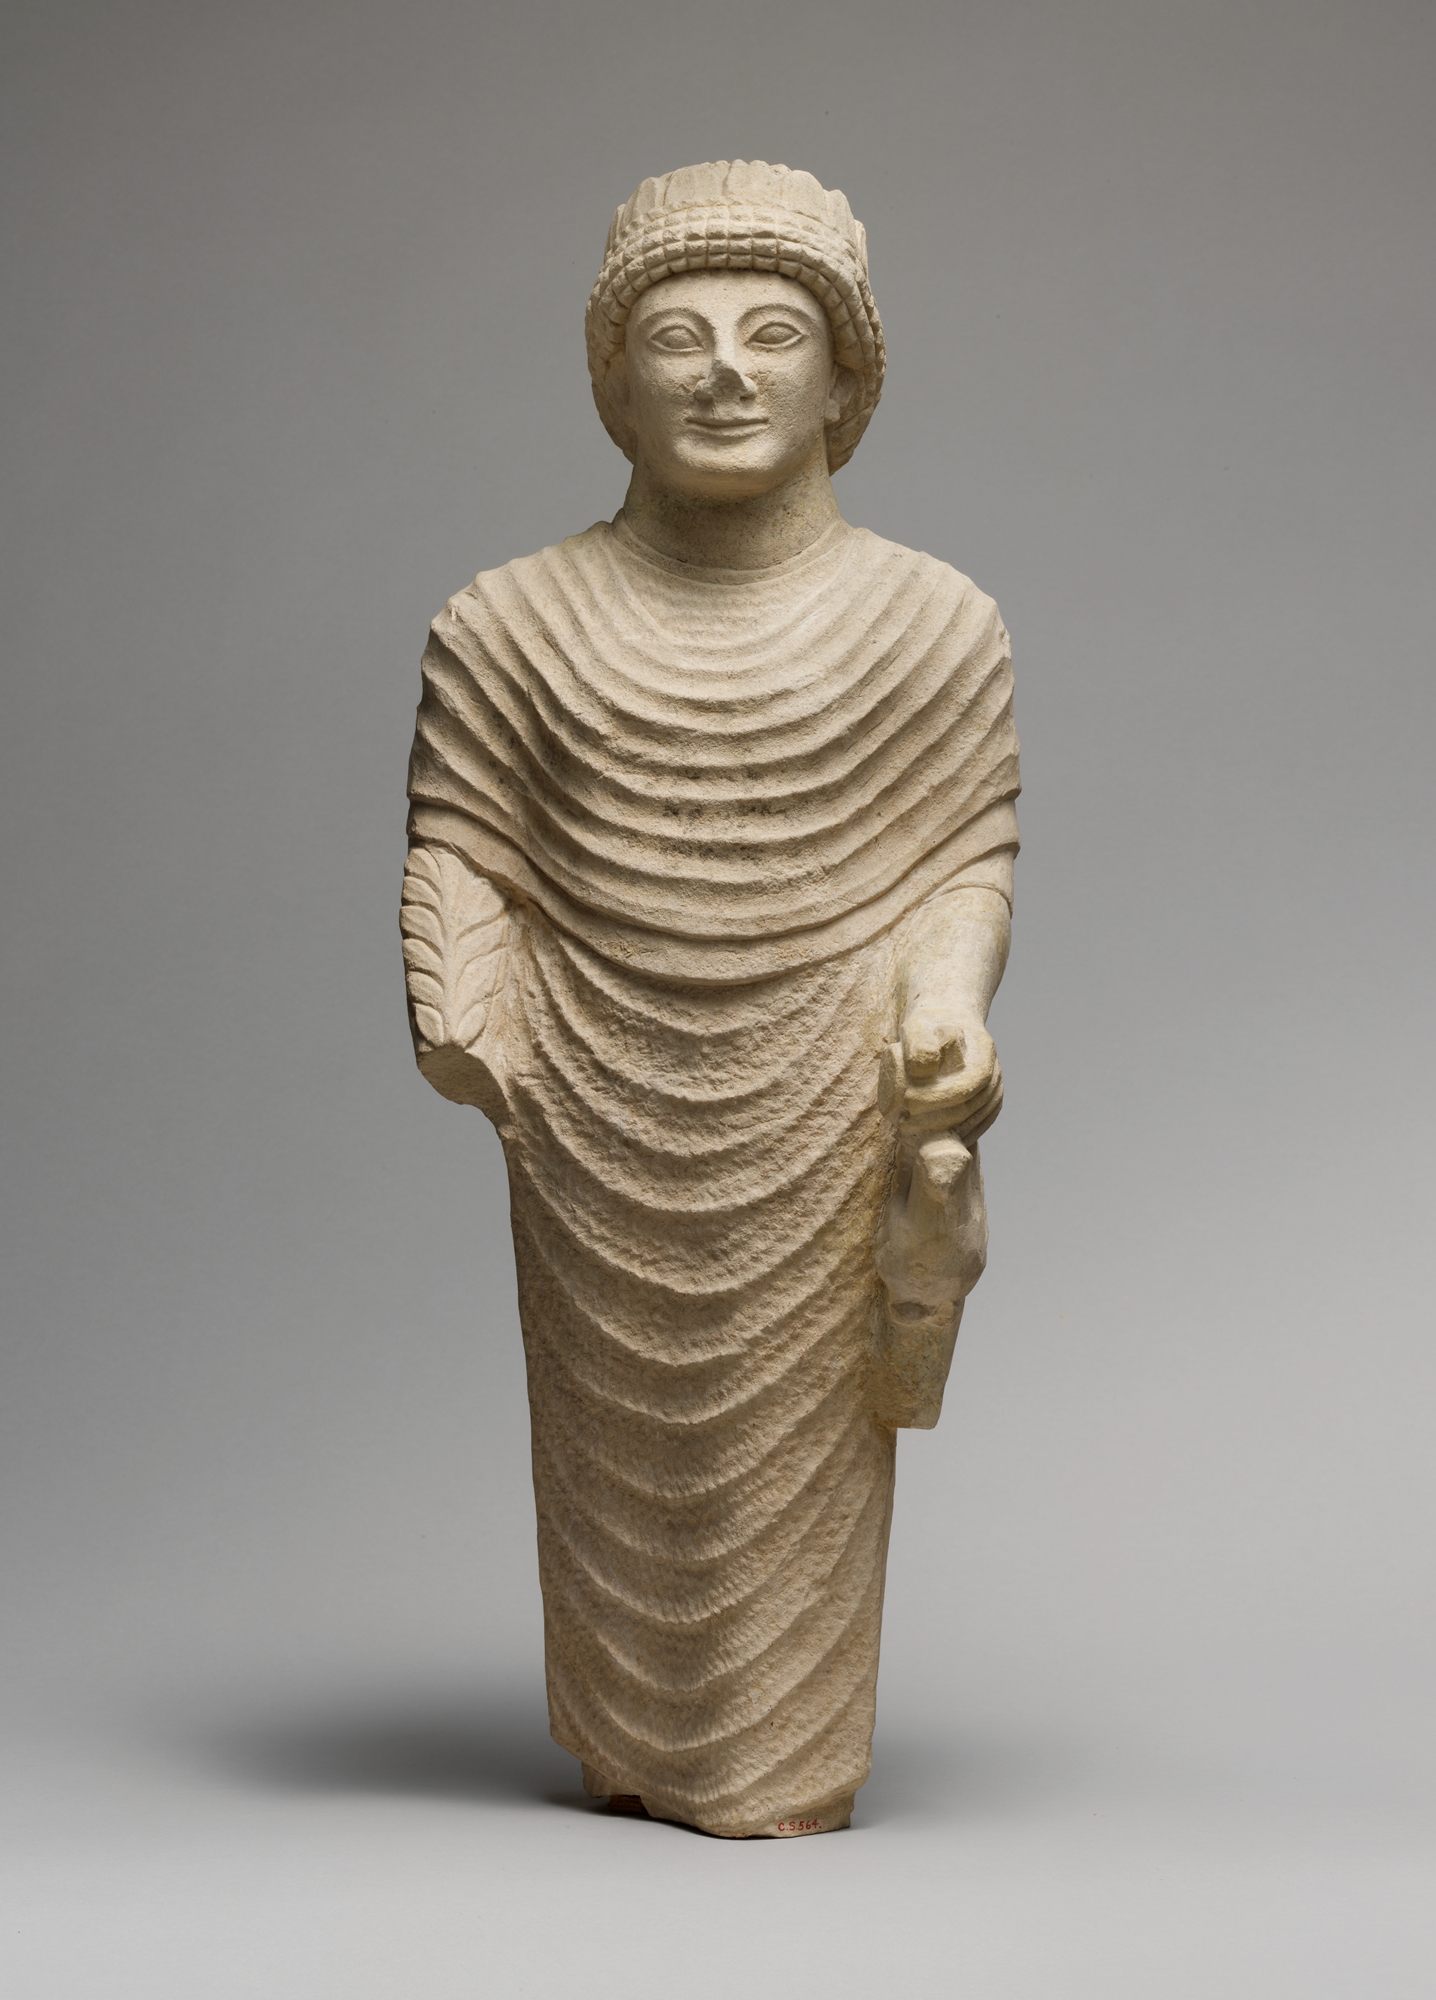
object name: statue of a male votary holding a bird in the left hand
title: Limestone statue of a male votary holding a bird in the left hand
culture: cypriot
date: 500-450 BCE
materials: limestone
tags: birds,men